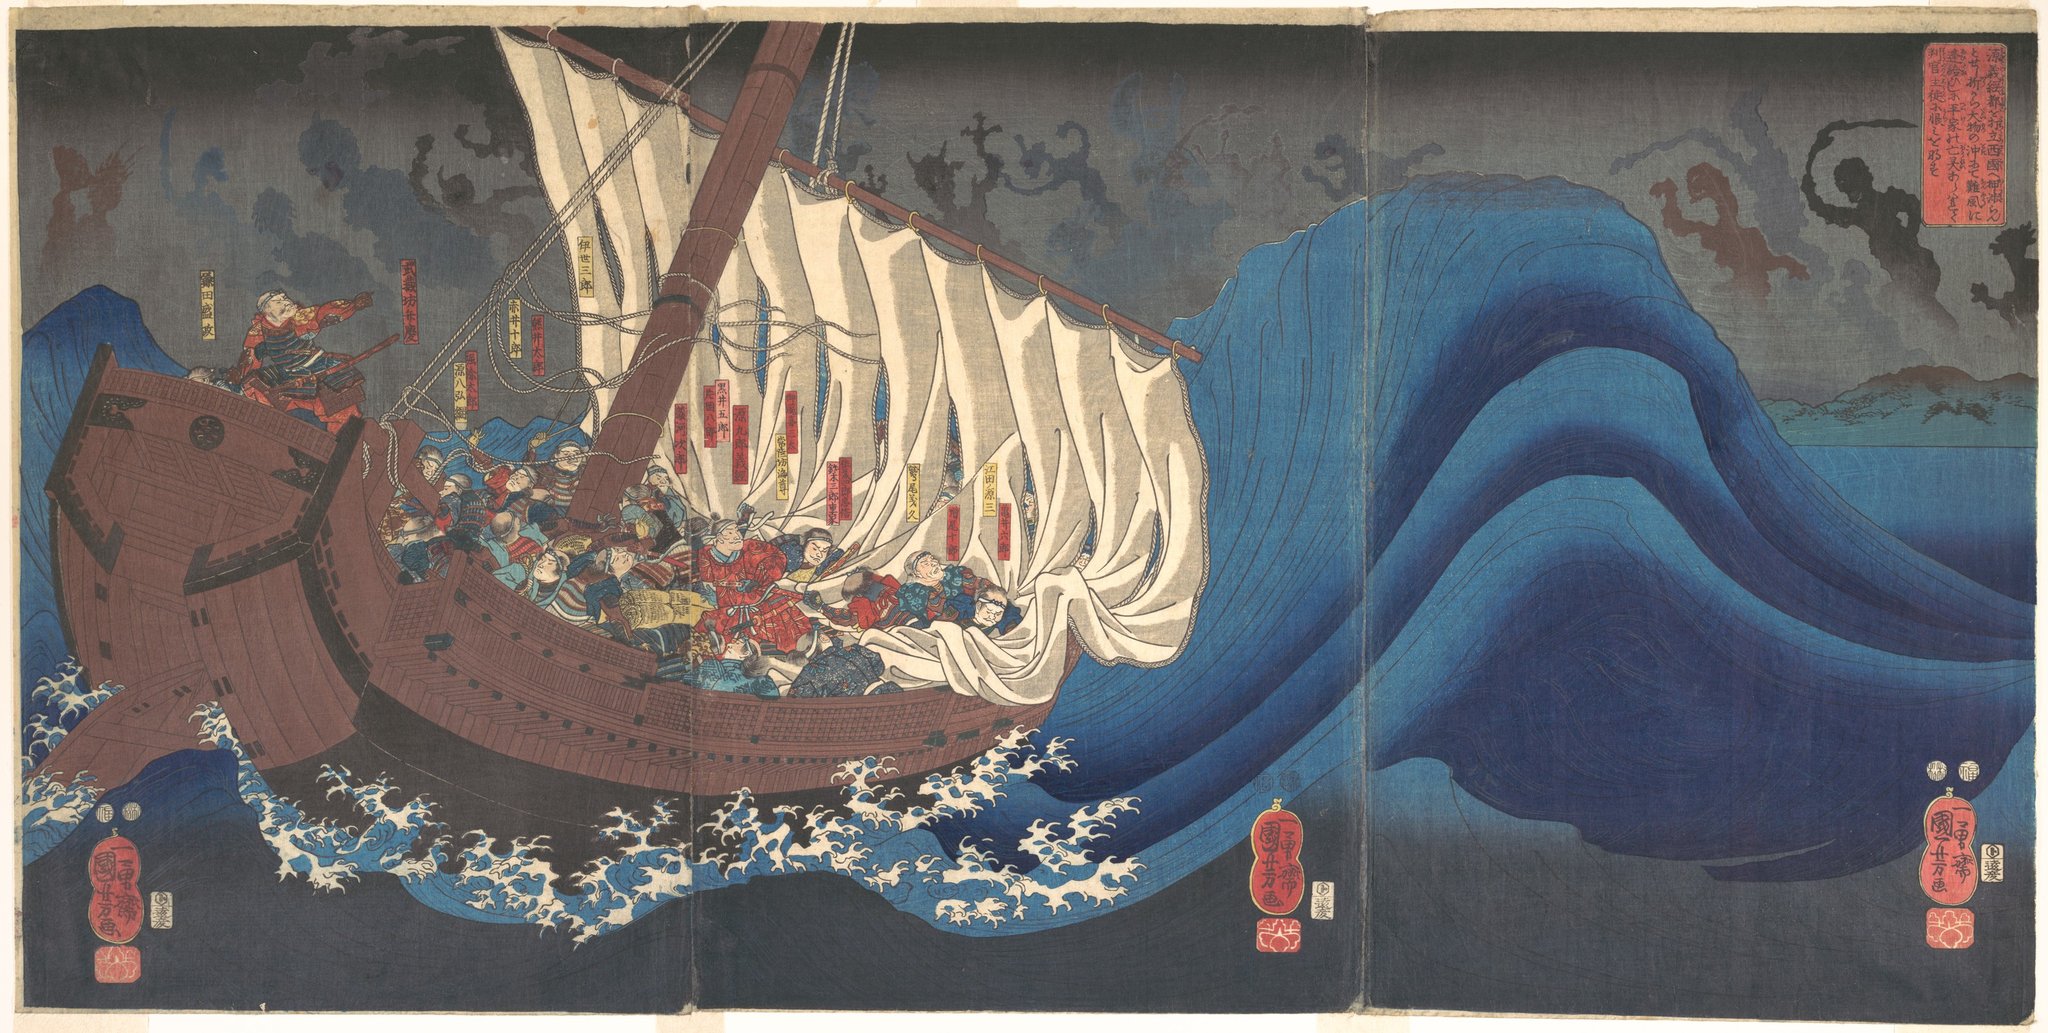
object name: woodblock print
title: Ghosts of the Taira at Daimotsu Bay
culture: japanese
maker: utagawa kuniyoshi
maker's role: artist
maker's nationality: japanese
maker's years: 1797-1861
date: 1843-1847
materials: ink, paper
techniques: nishiki e, woodblock print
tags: men,waves,boats